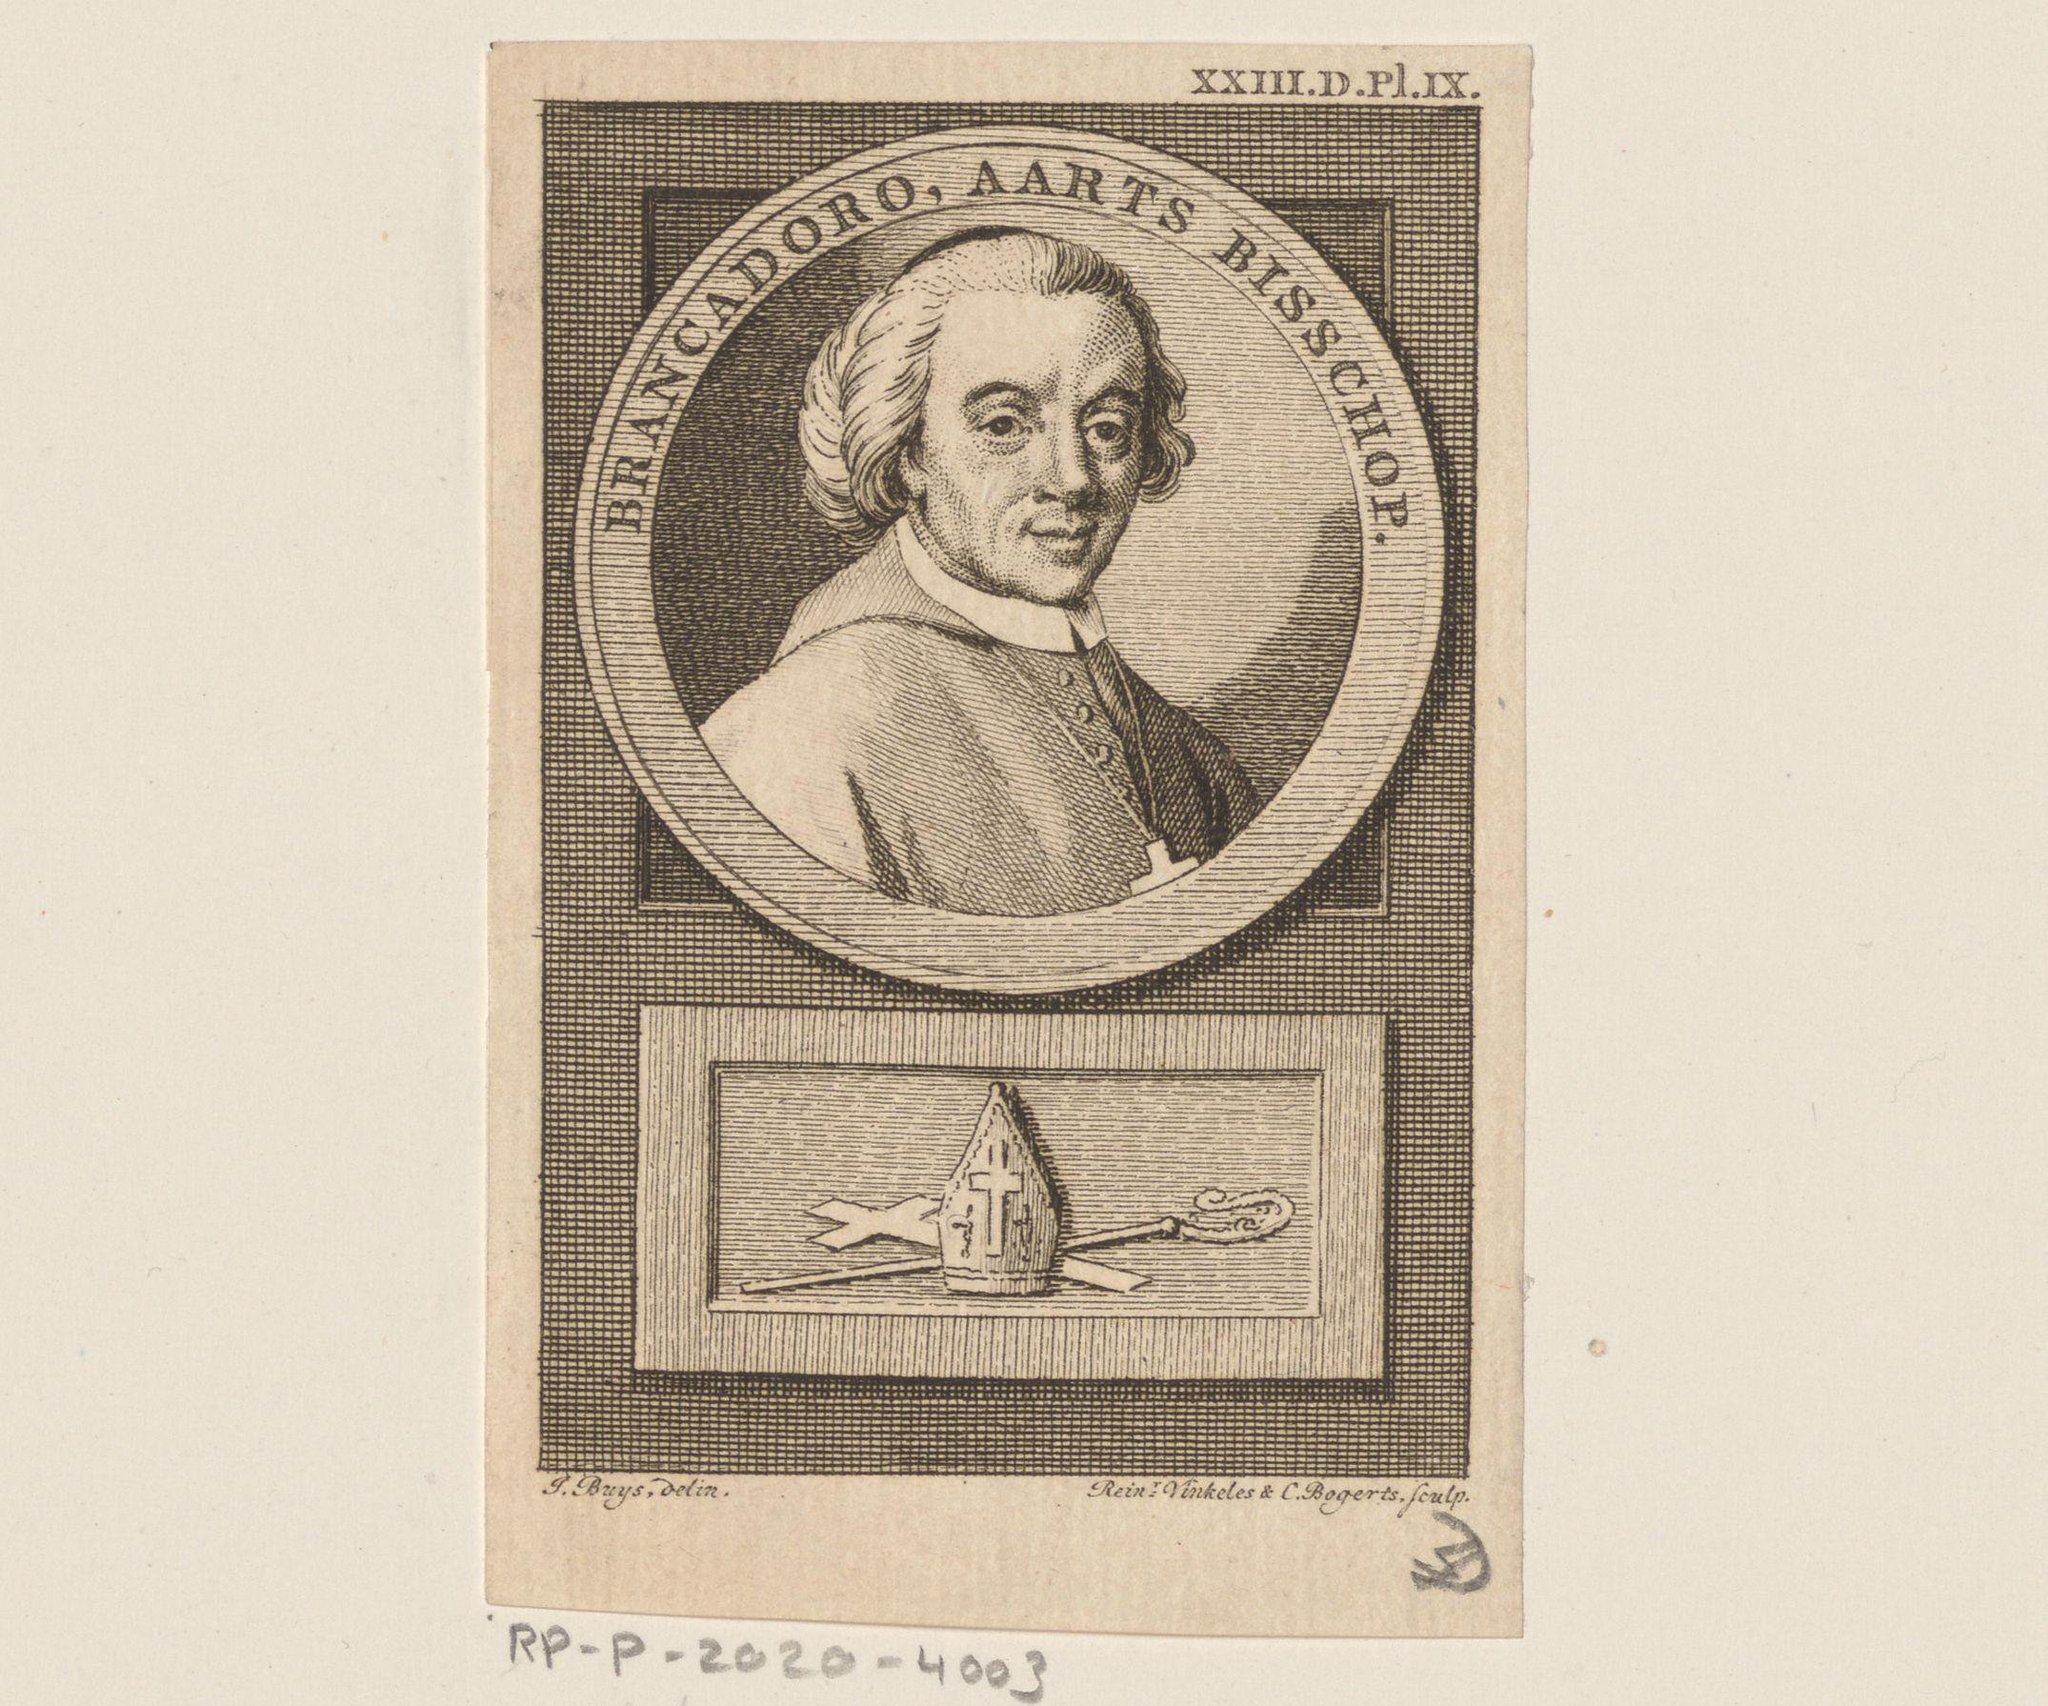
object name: print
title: Portret van Cesare Brancadoro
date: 1783-1795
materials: paper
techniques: engraving, etching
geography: amsterdam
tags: rome, cardinal, historical persons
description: Prent uit: Fokke, Jan. Geschiedenissen der Vereenigde Nederlanden voor de vaderlandsche jeugd (...). Amsterdam: Johannes Allart, 1783-1795, dl. 23.